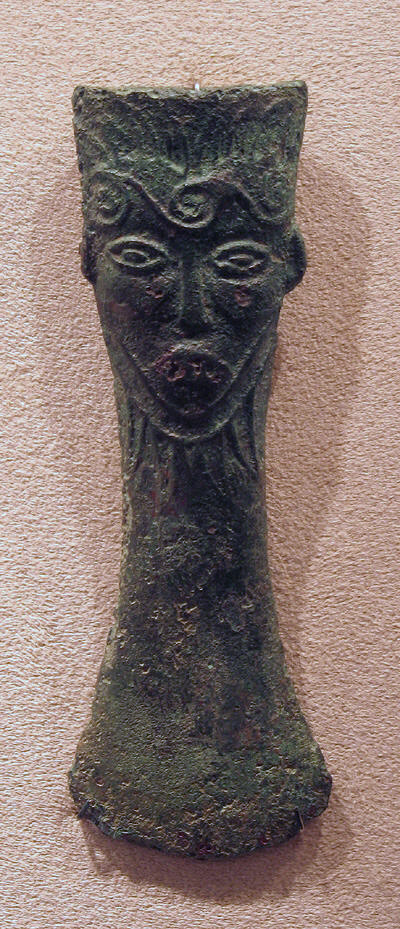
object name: ax head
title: Ax Head with Bearded Face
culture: indonesian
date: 500 BCE-300 CE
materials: bronze